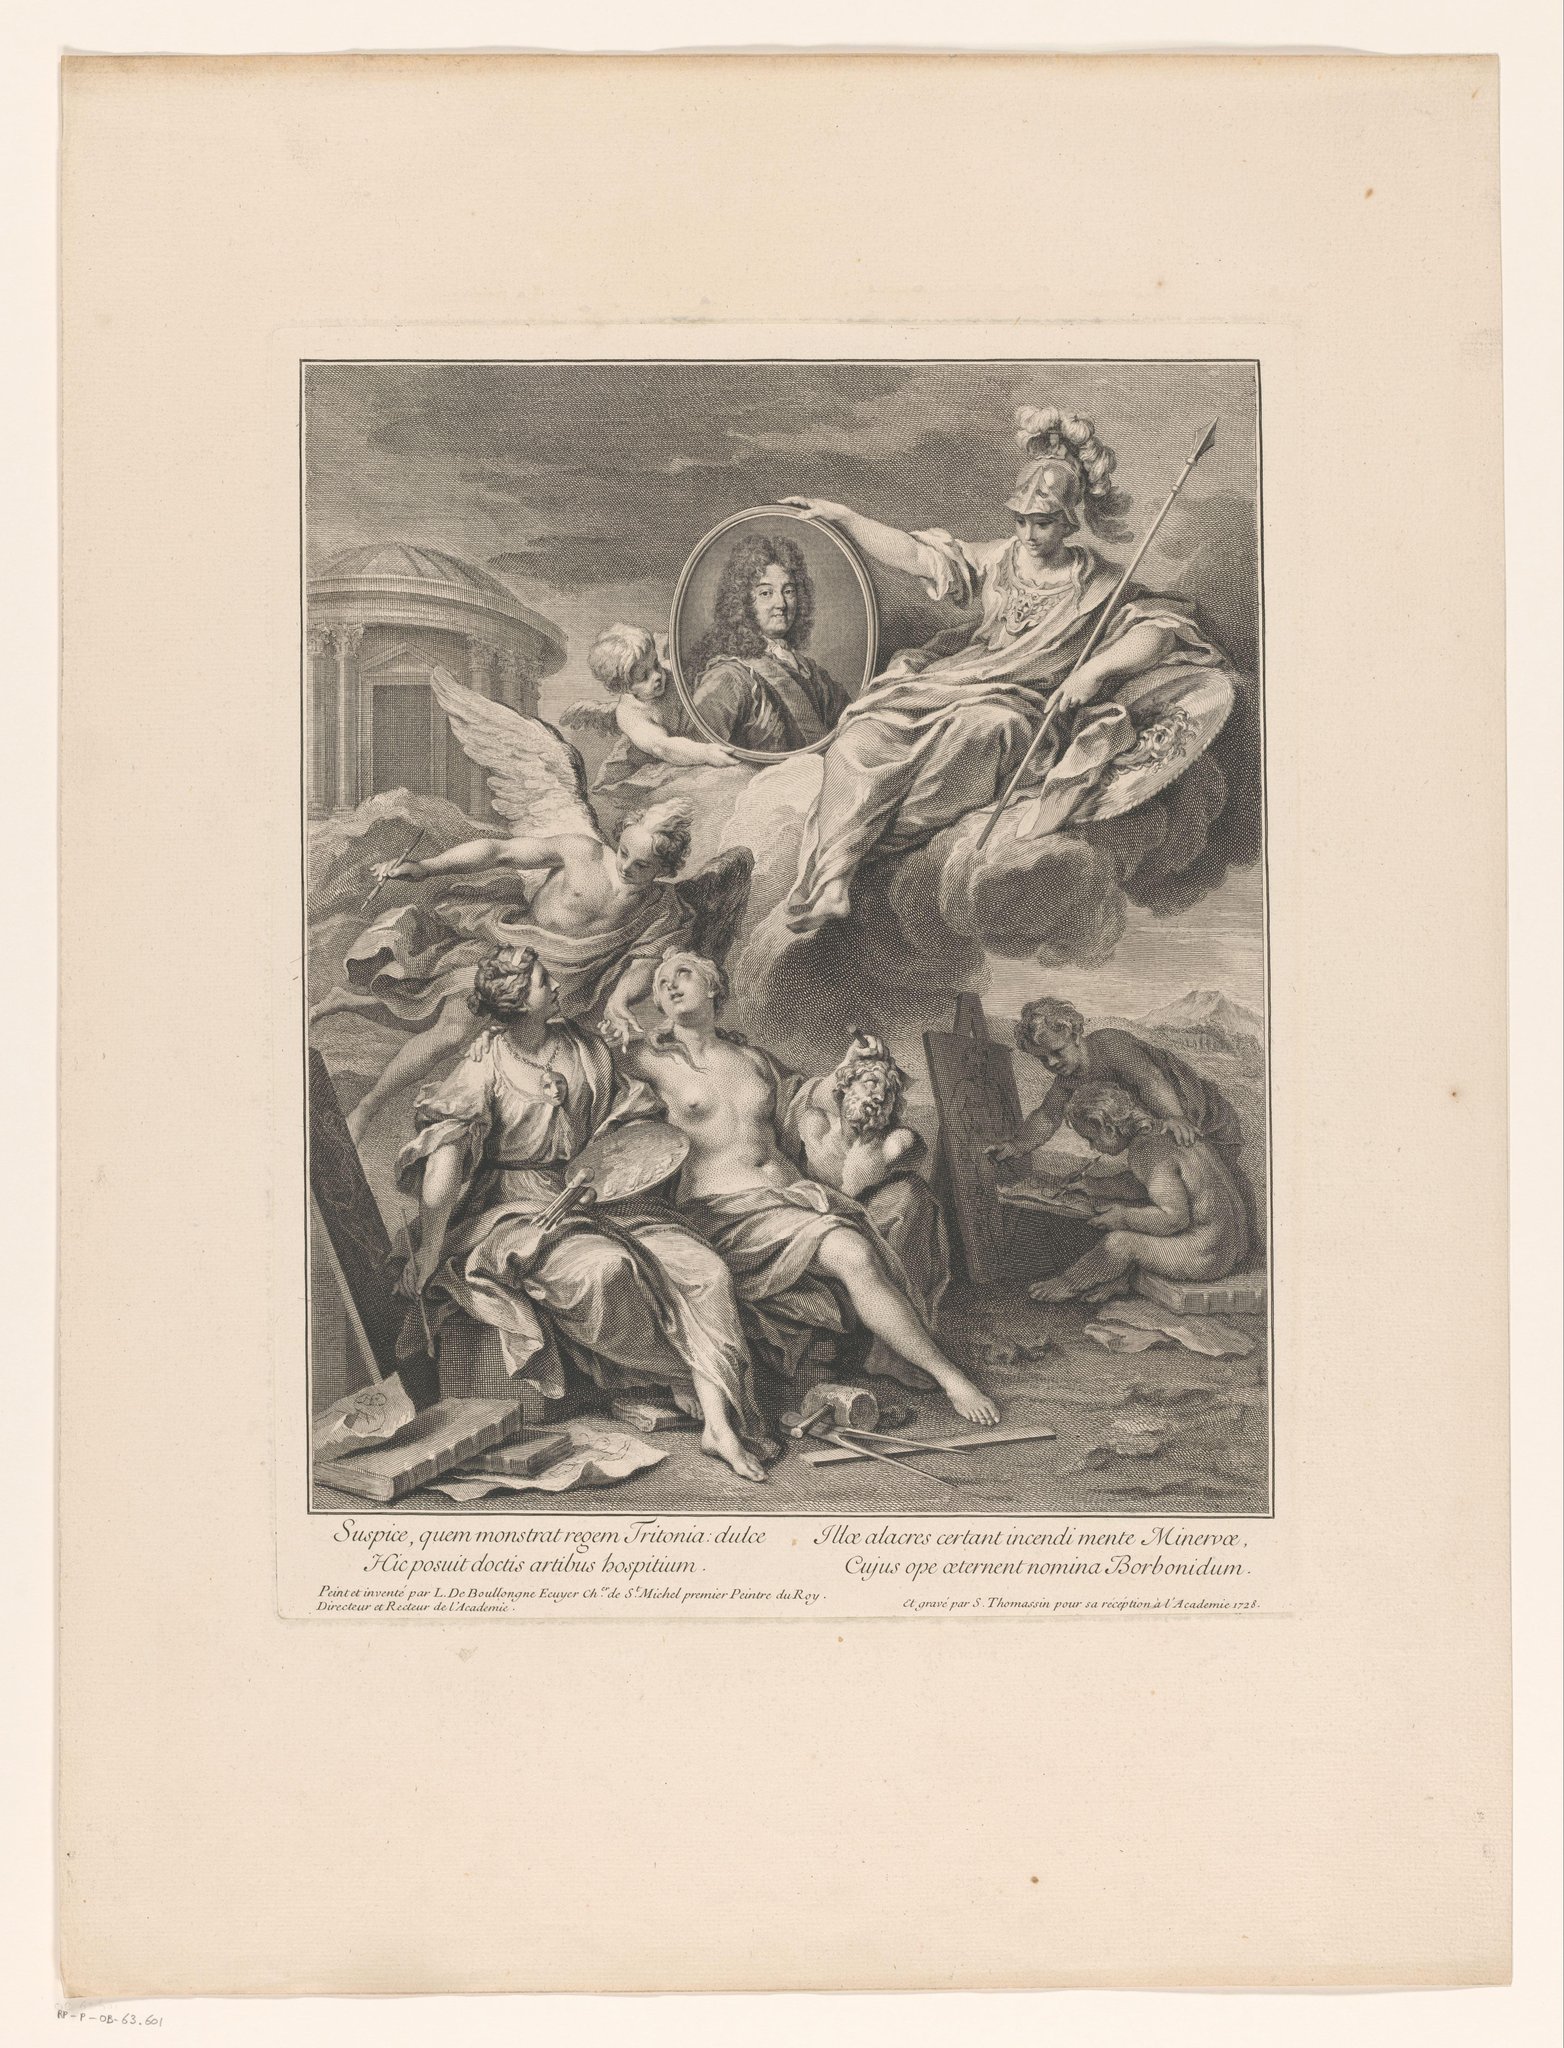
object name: print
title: Medaillon met een portret van een lid van de familie Bourbon door Minerva voorgehouden aan de Schilderkunst en de Beeldhouwkunst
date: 1728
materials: paper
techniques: engraving, etching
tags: 'pictura', symbolic representations, allegories and emblems ~ painting; 'pittura' (ripa), 'sculptura', symbolic representations, allegories and emblems ~ sculpture; 'scoltura' (ripa), (story of) minerva (pallas, athena), historical persons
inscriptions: collector's mark: Lugt 240